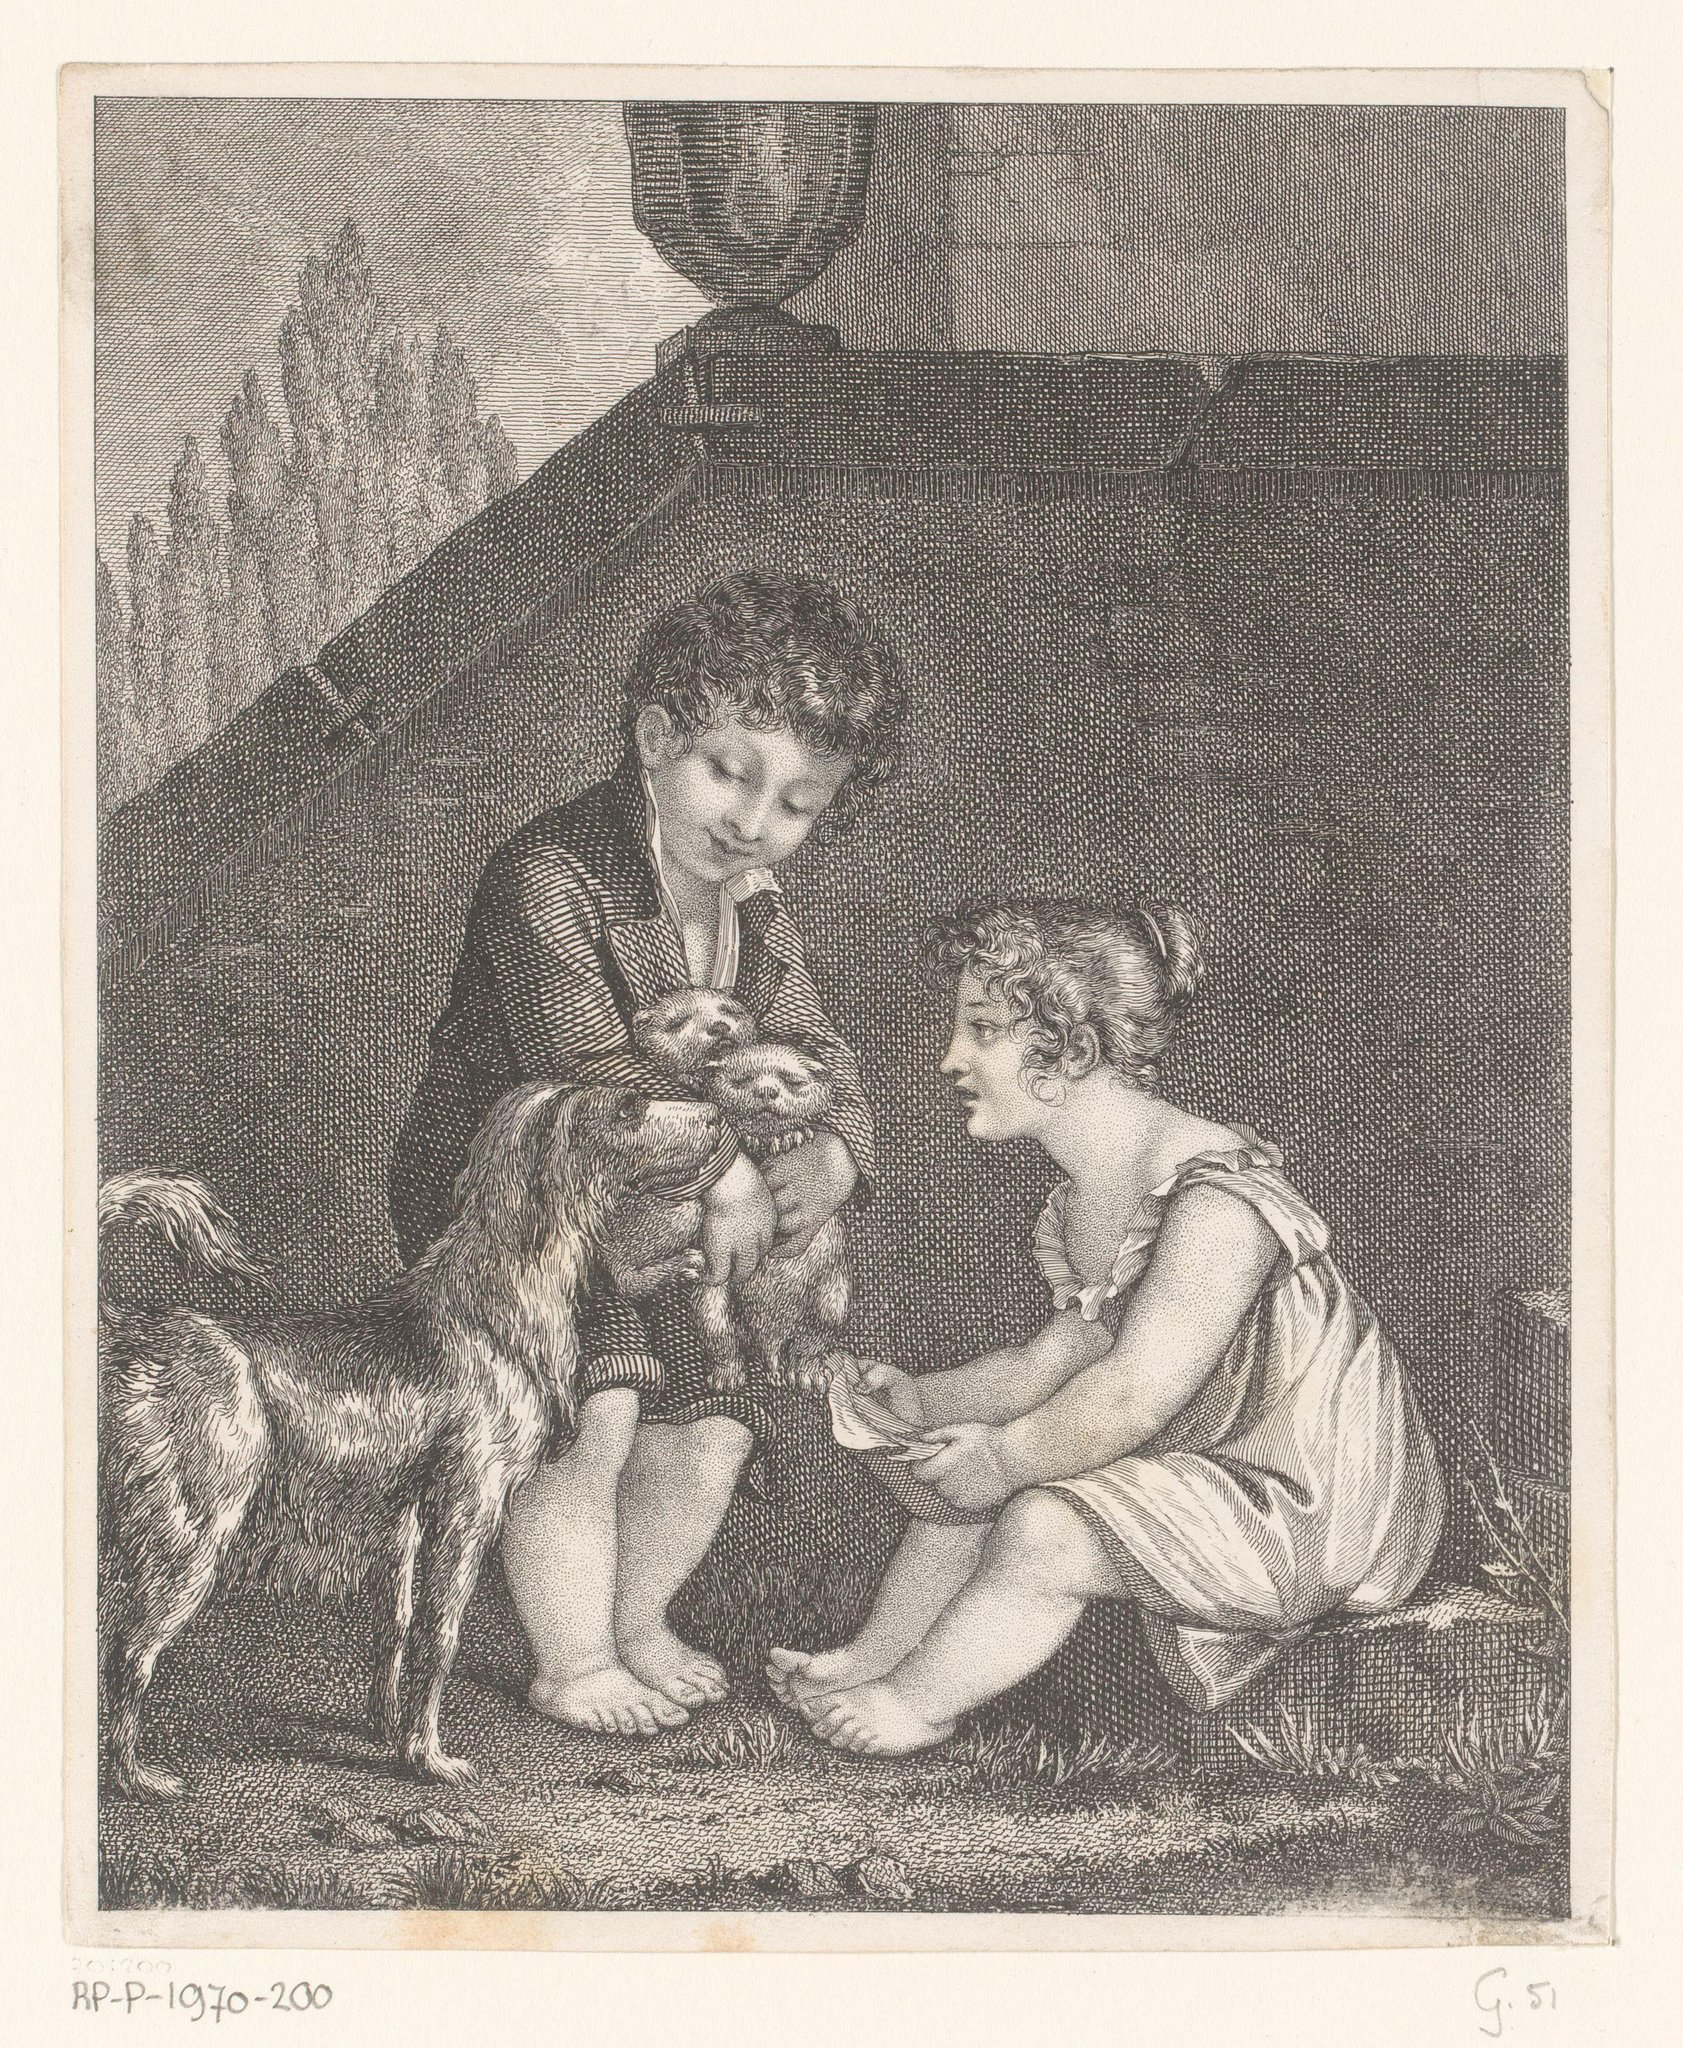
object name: print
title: Oh, les jolis petits chiens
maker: Anonymous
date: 1780-1850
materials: paper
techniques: engraving, etching, roulette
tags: child, child playing with animals, dog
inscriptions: collector's mark: Lugt 2228, collector's mark: Lugt 2760